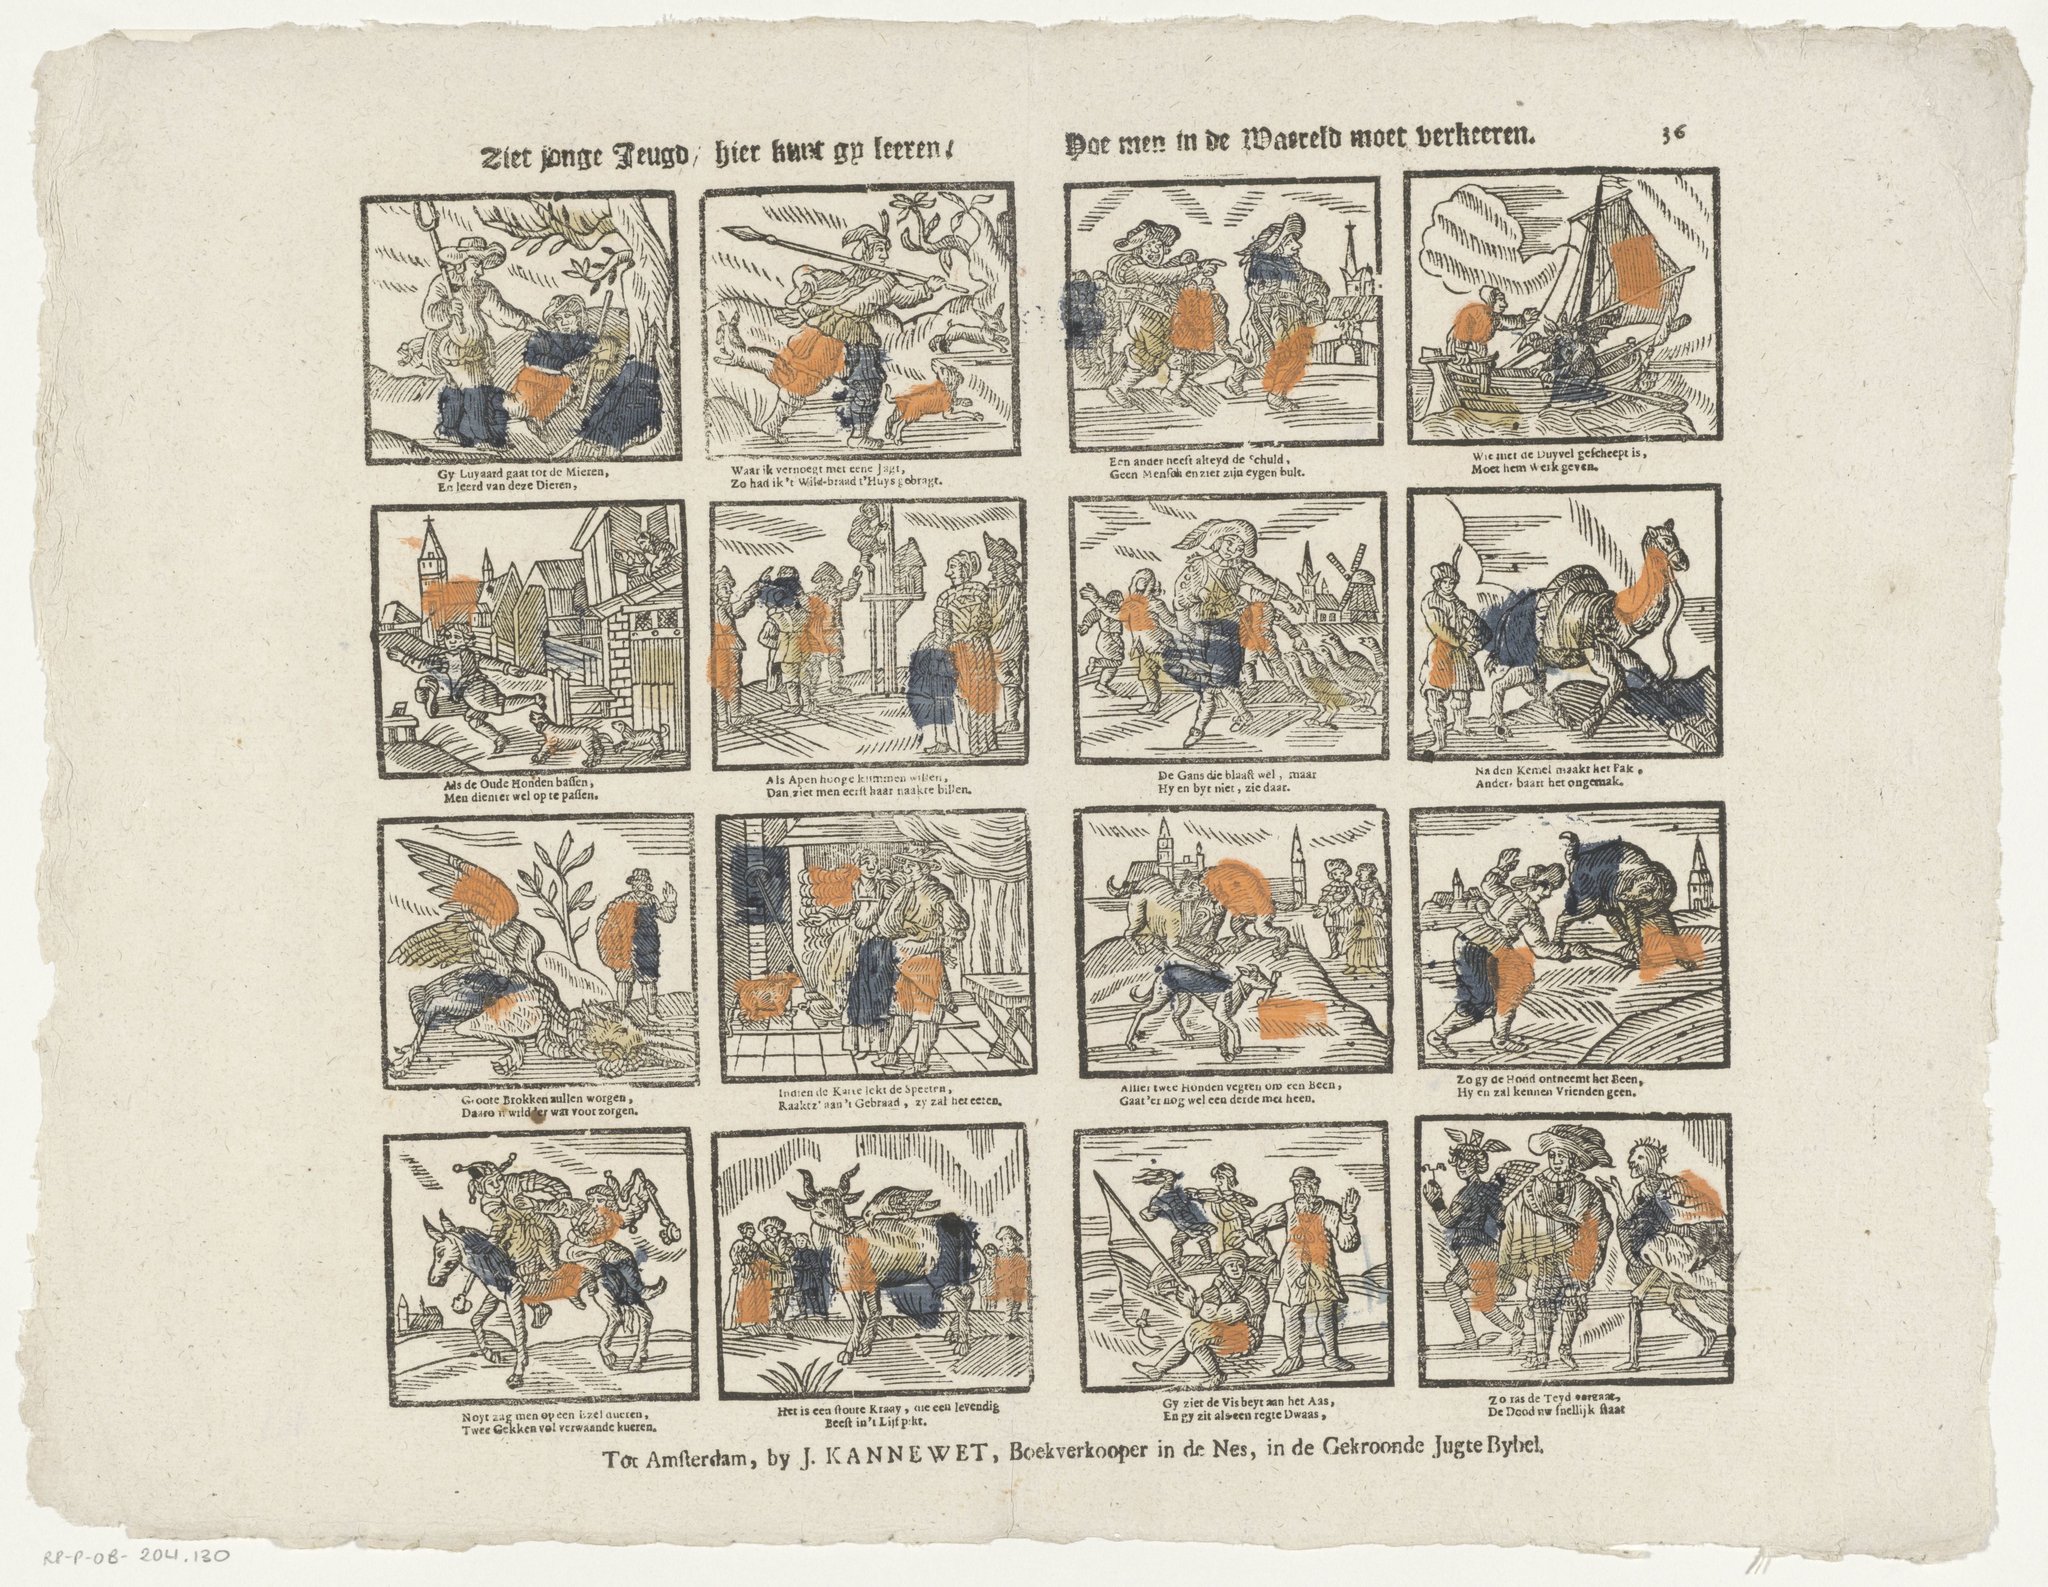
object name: print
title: Ziet jonge jeugd / hier kunt gy leeren / Hoe men in de waereld moet verkeeren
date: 1725-1780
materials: paper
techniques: colour, letterpress printing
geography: amsterdam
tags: proverbs, sayings, etc.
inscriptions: collector's mark: Lugt 2760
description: Blad met 16 verbeeldingen van spreekwoorden. Onder elke afbeelding een tweeregelig vers. Genummerd rechtsboven: 36.